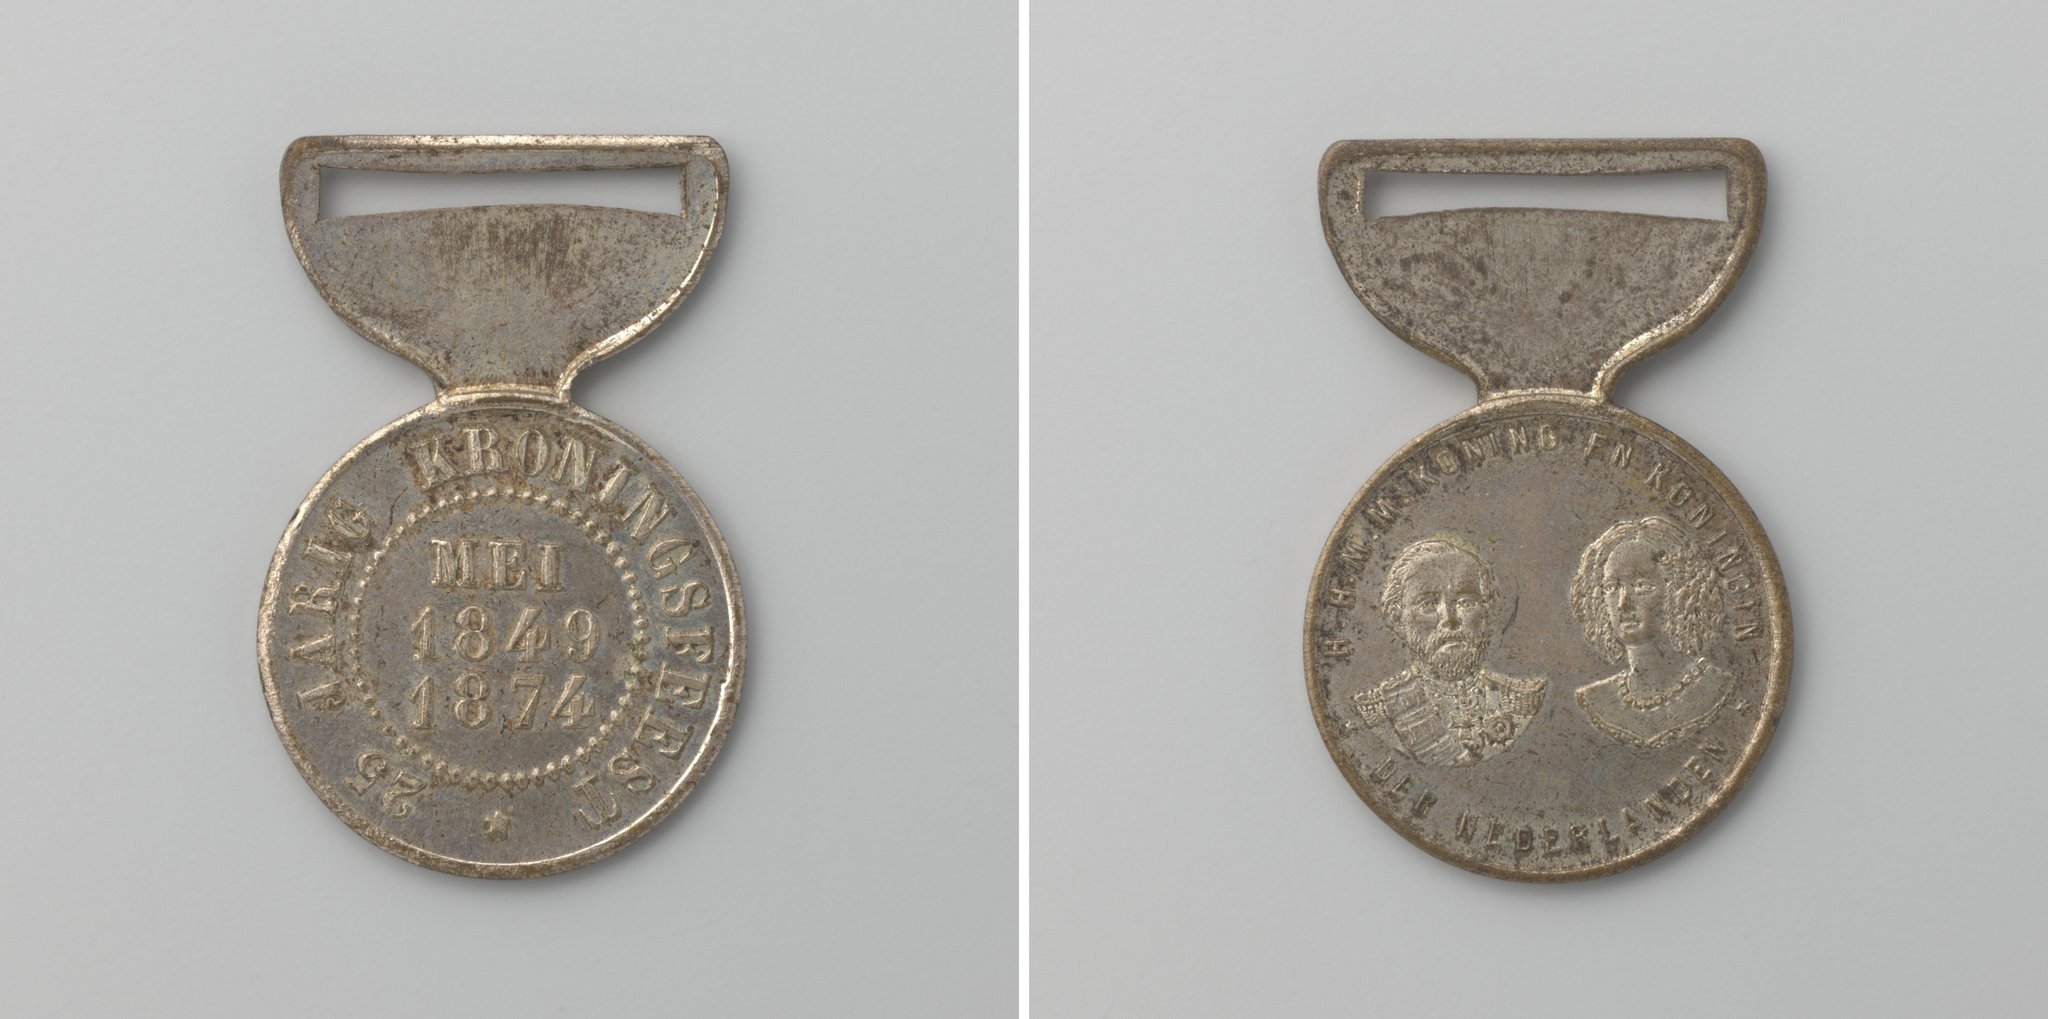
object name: history medal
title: Vijfentwintigjarig regeringsjubileum van Koning Willem III en Koningin Sophia 1874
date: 1874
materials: brass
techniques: striking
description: Draaggesp met medaillon van verzilverd messing, op de voorzijde de aanziende portretten van Willem III en Sophia met omschrift, op de keerzijde drie regels tekst met omschrift.